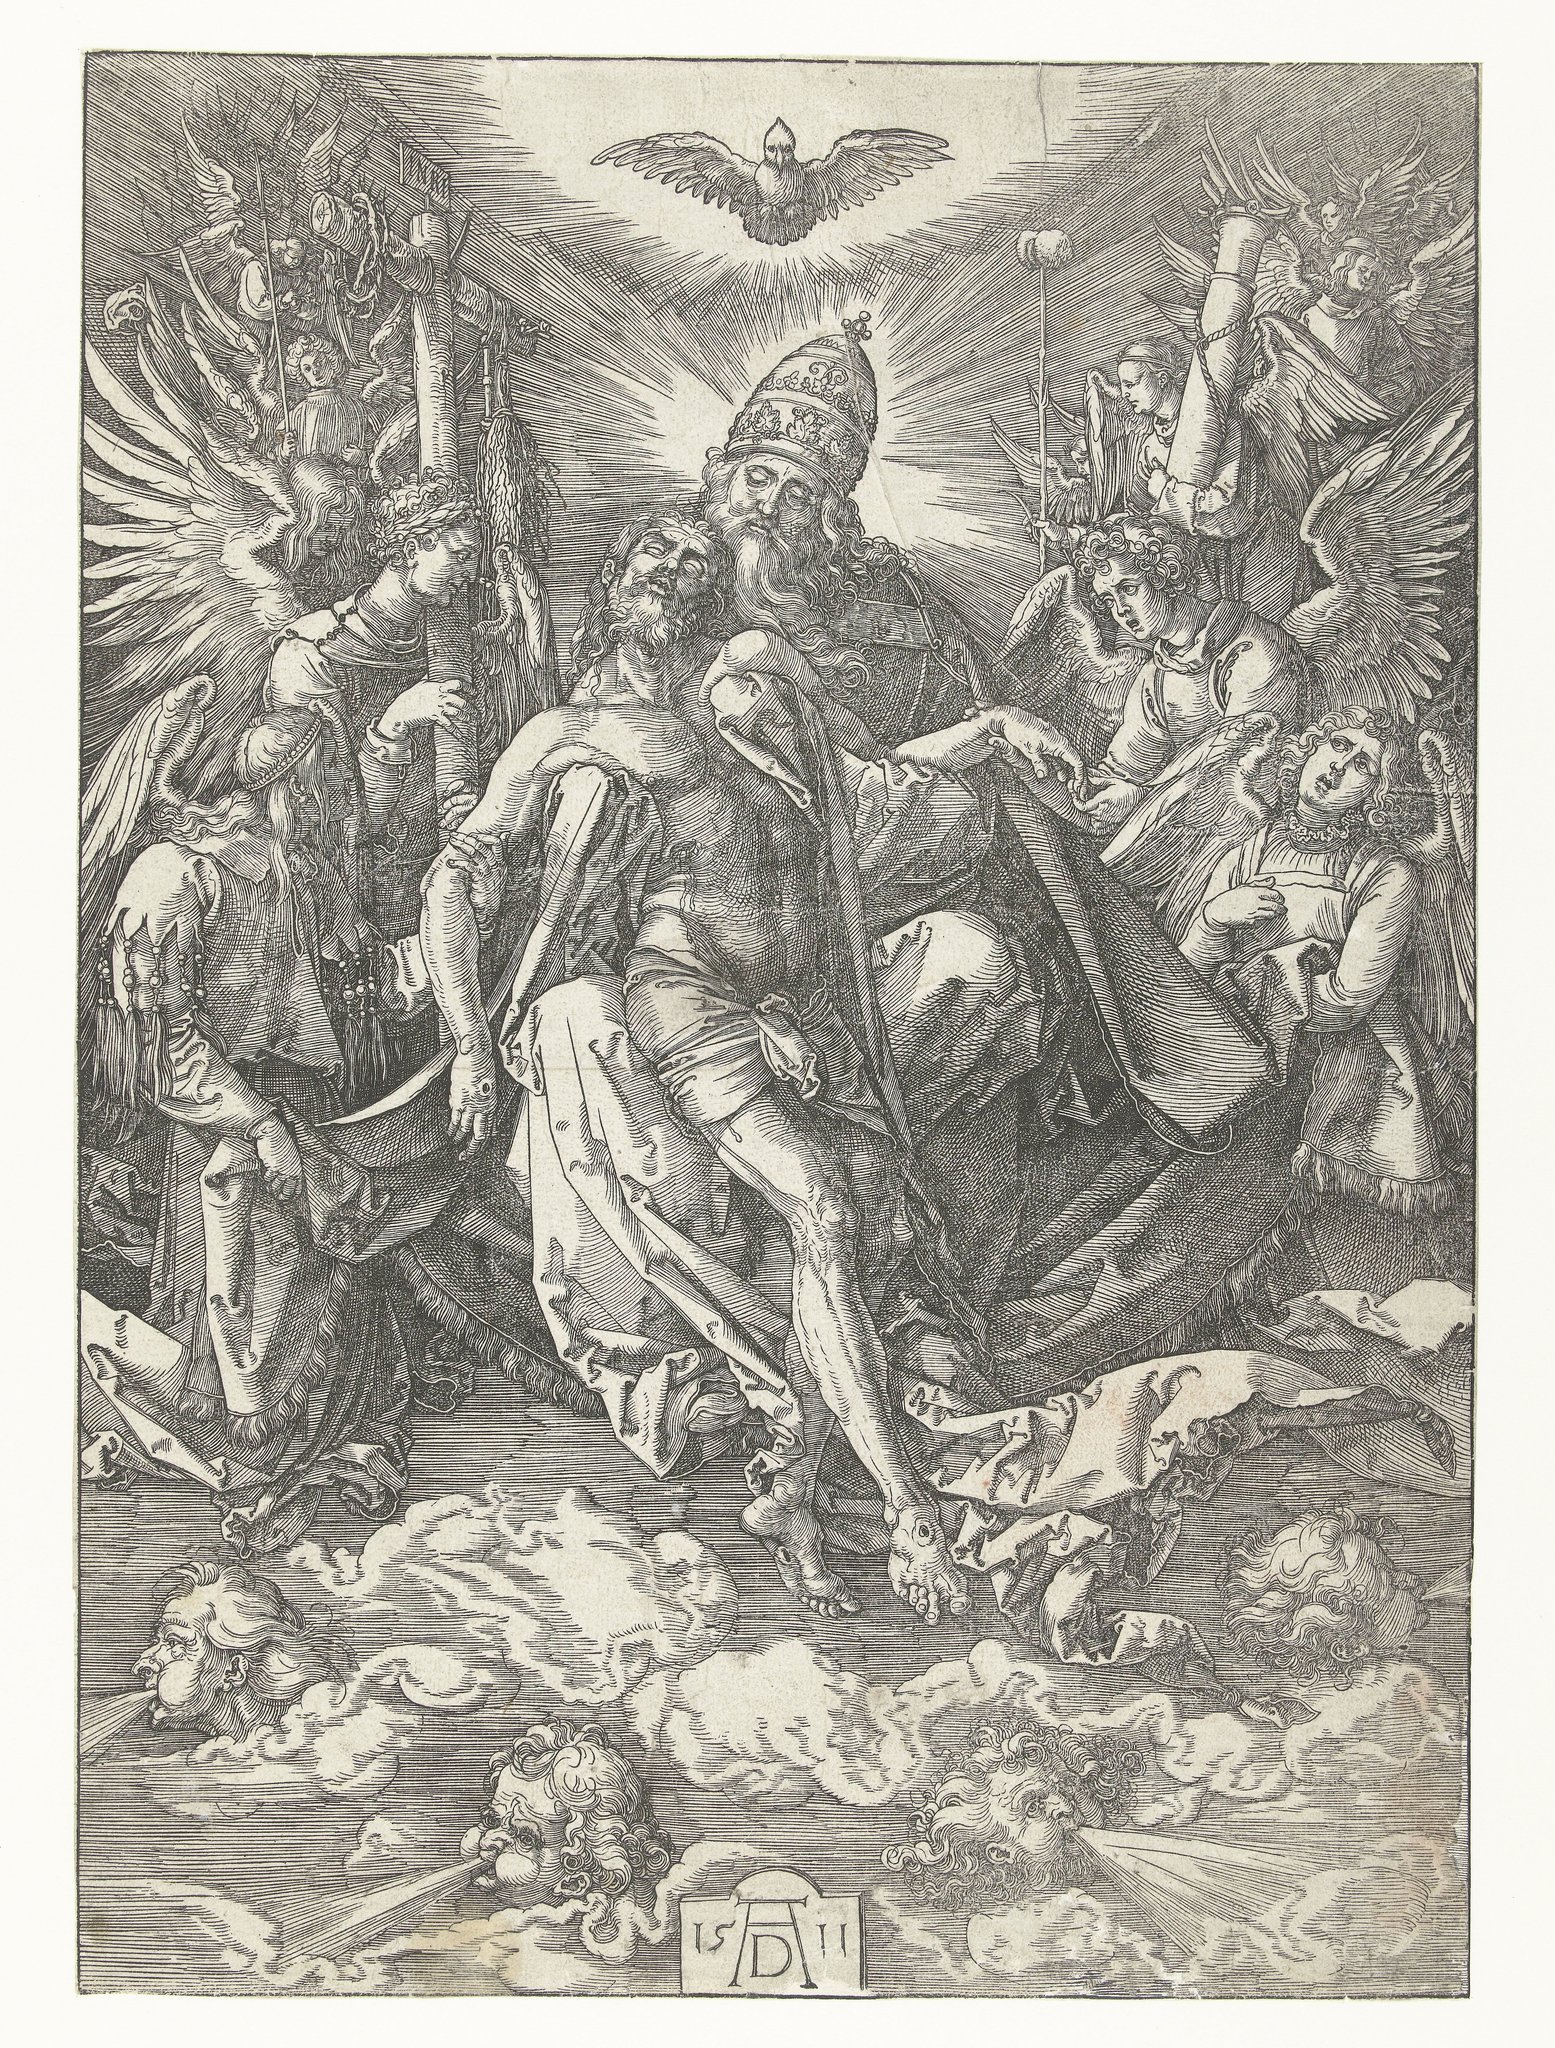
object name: print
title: De Heilige Drie-eenheid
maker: albrecht dürer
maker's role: draughtsman, painter, print maker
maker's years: 1471-1528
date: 1511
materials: paper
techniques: woodcut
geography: nuremberg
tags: 'arma christi', trinity in which god the father and christ are represented as persons, the holy ghost as dove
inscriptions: date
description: God houdt de gestorven Christus in de armen, terwijl boven hen de Heilige Geest in de gedaante van een duif zweeft. Om hen heen engelen met de passiewerktuigen.